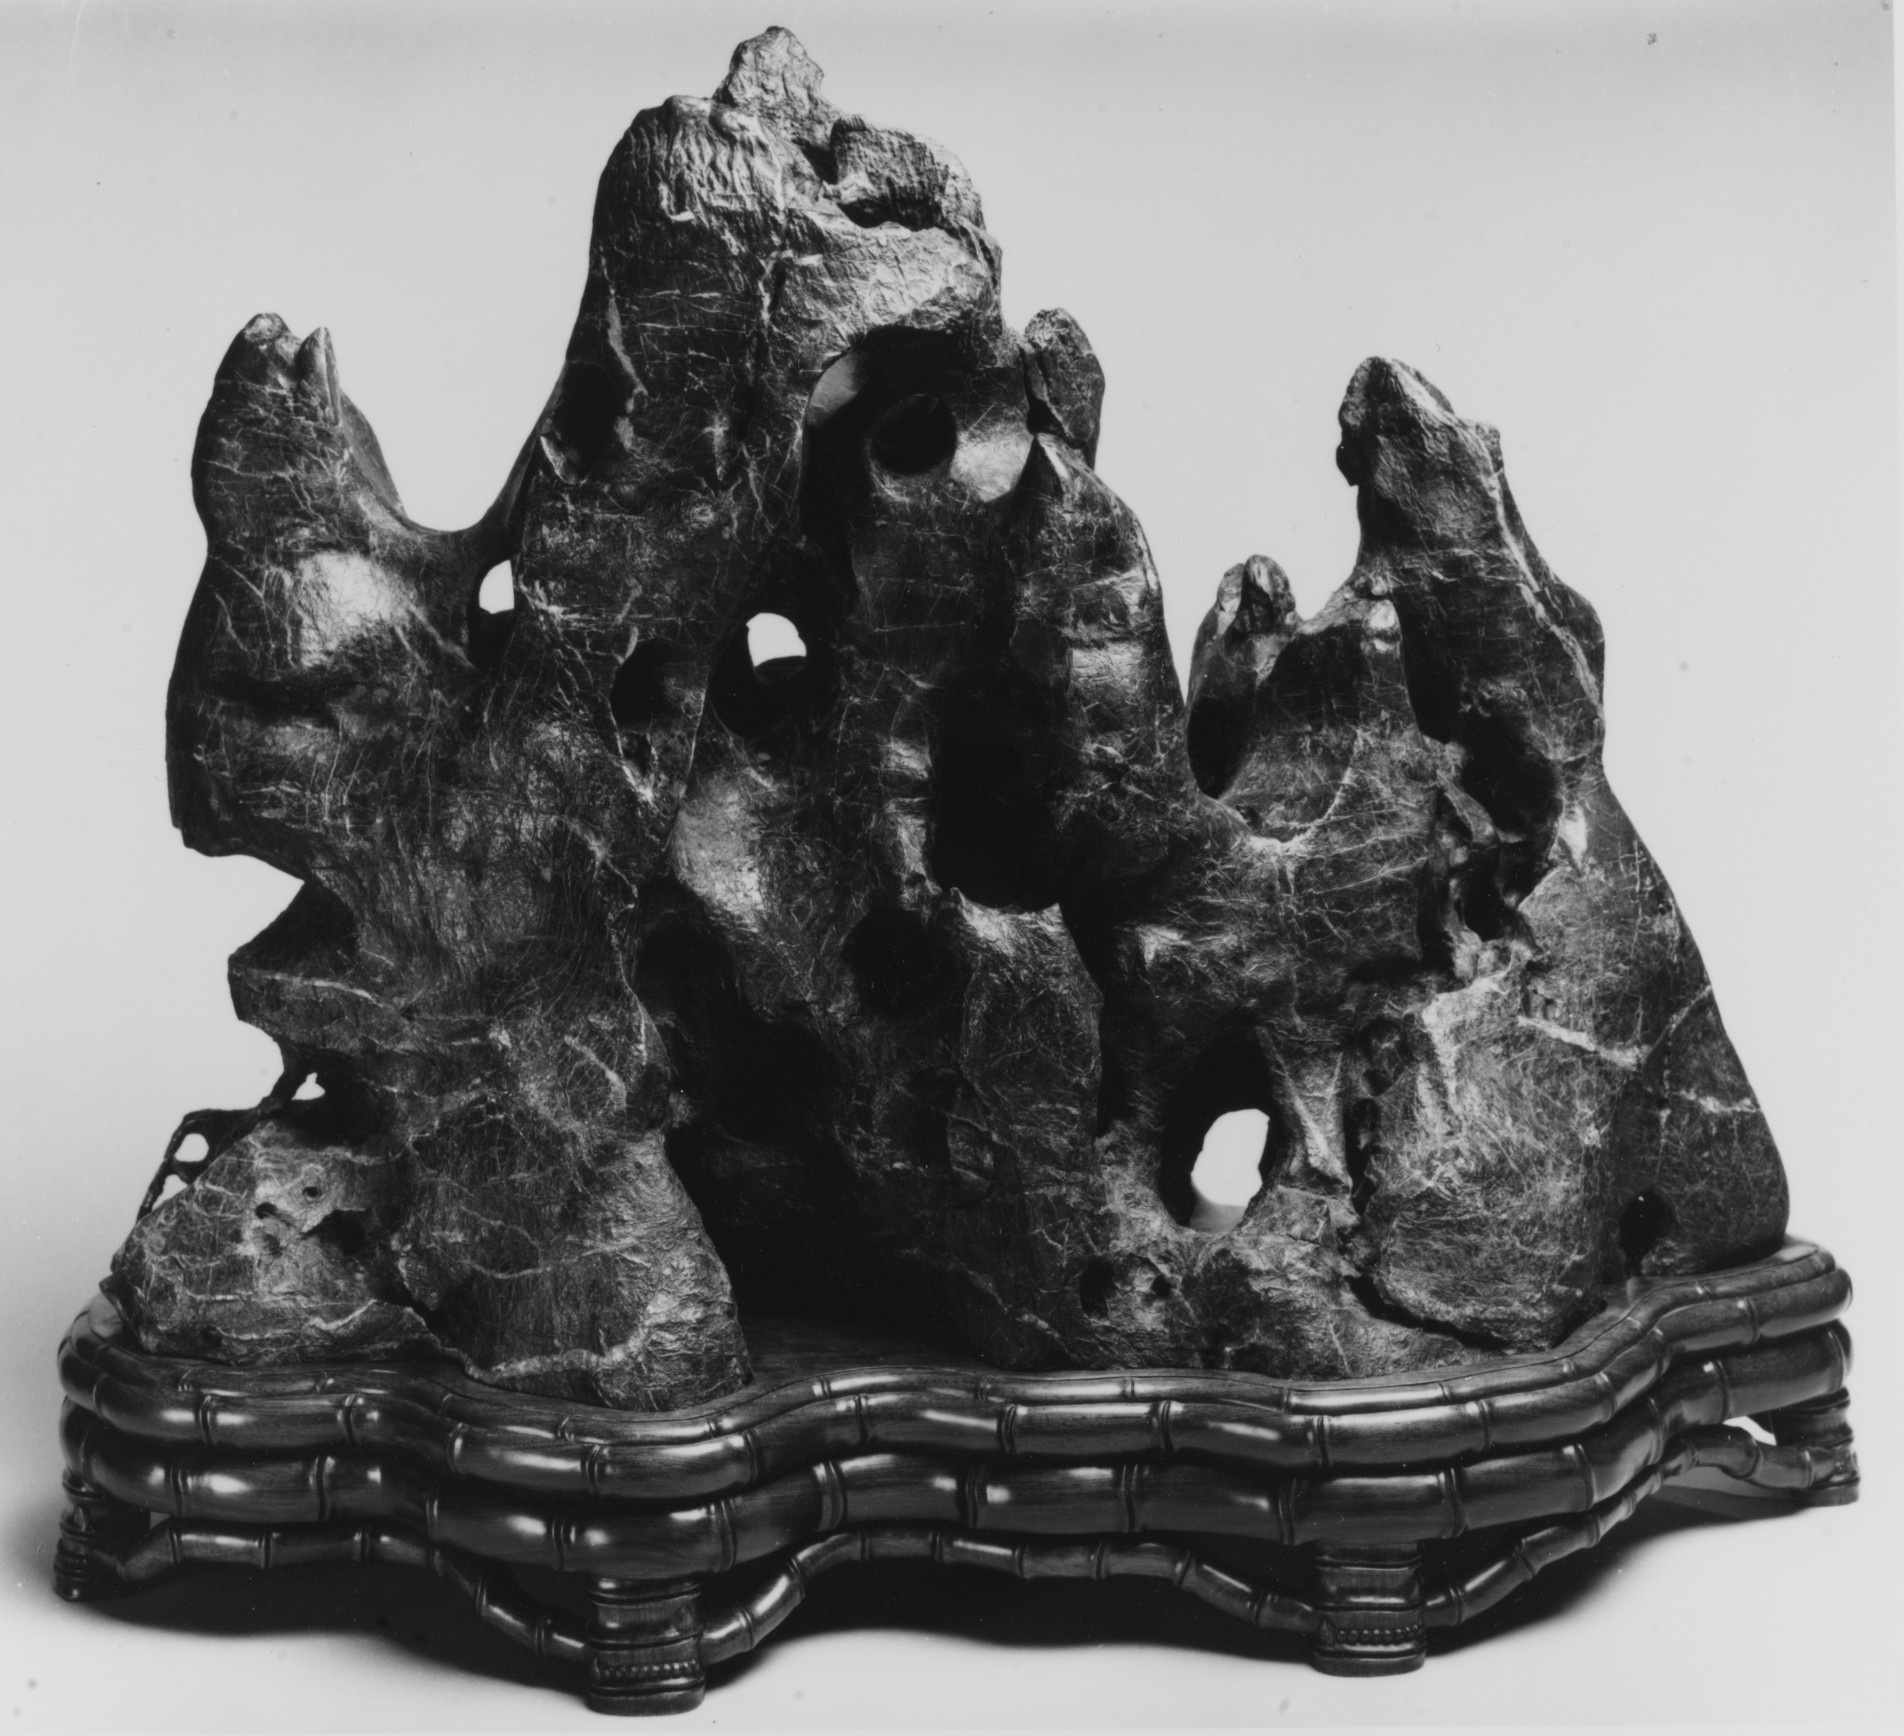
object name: scholar's rock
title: Rock in the Form of a Fantastic Mountain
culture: chinese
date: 1701-1900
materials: limestone, wood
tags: mountains